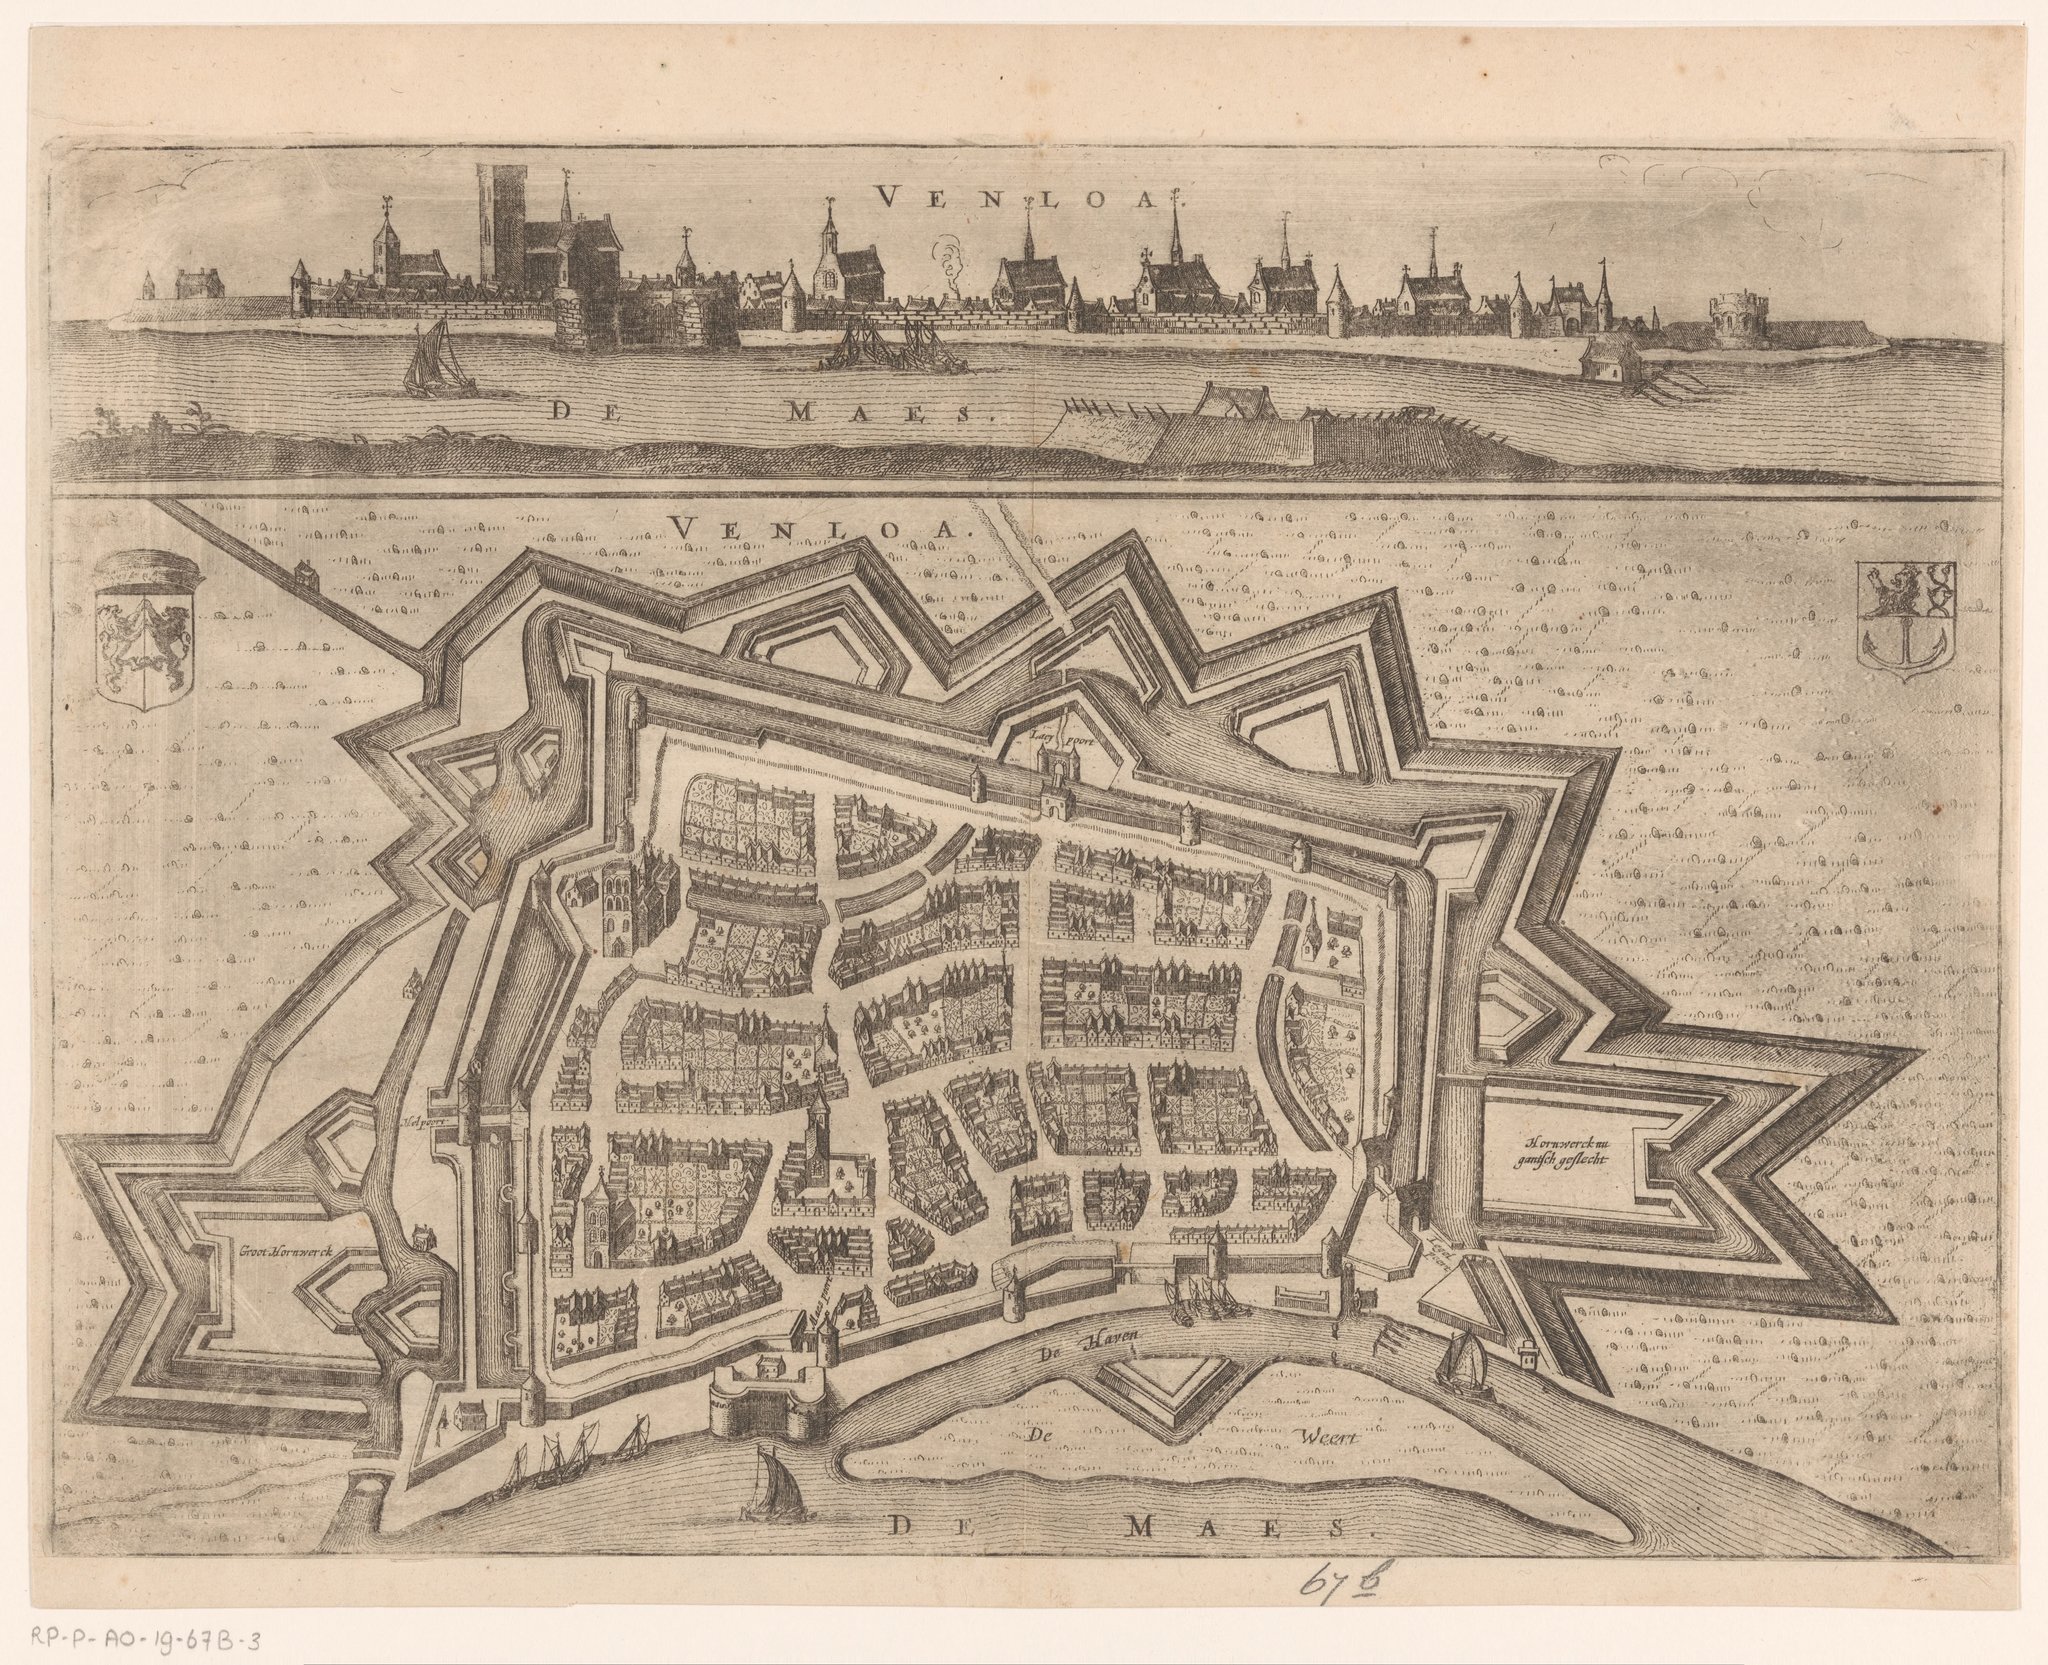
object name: book illustration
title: Venloa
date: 1653-1672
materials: paper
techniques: engraving, etching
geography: arnhem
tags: coat of arms (as symbol of the state, etc.) (+ city; municipal), maps of cities, coat of arms (as symbol of the state, etc.) (+ province; provincial), prospect of city, town panorama, silhouette of city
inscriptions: collector's mark: Lugt 2228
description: Prent ook gebruikt in: Slichtenhorst, Arend van. XIV boeken van de Geldersse geschiedenissen (...) Arnhem: Jacob van Biesen, 1653-1654. En in: Slichtenhorst, Arend van. Cartes géographiques du duché de Gueldre et comté de Zutphen (...) Arnhem: Jacob van Biesen, 1672.